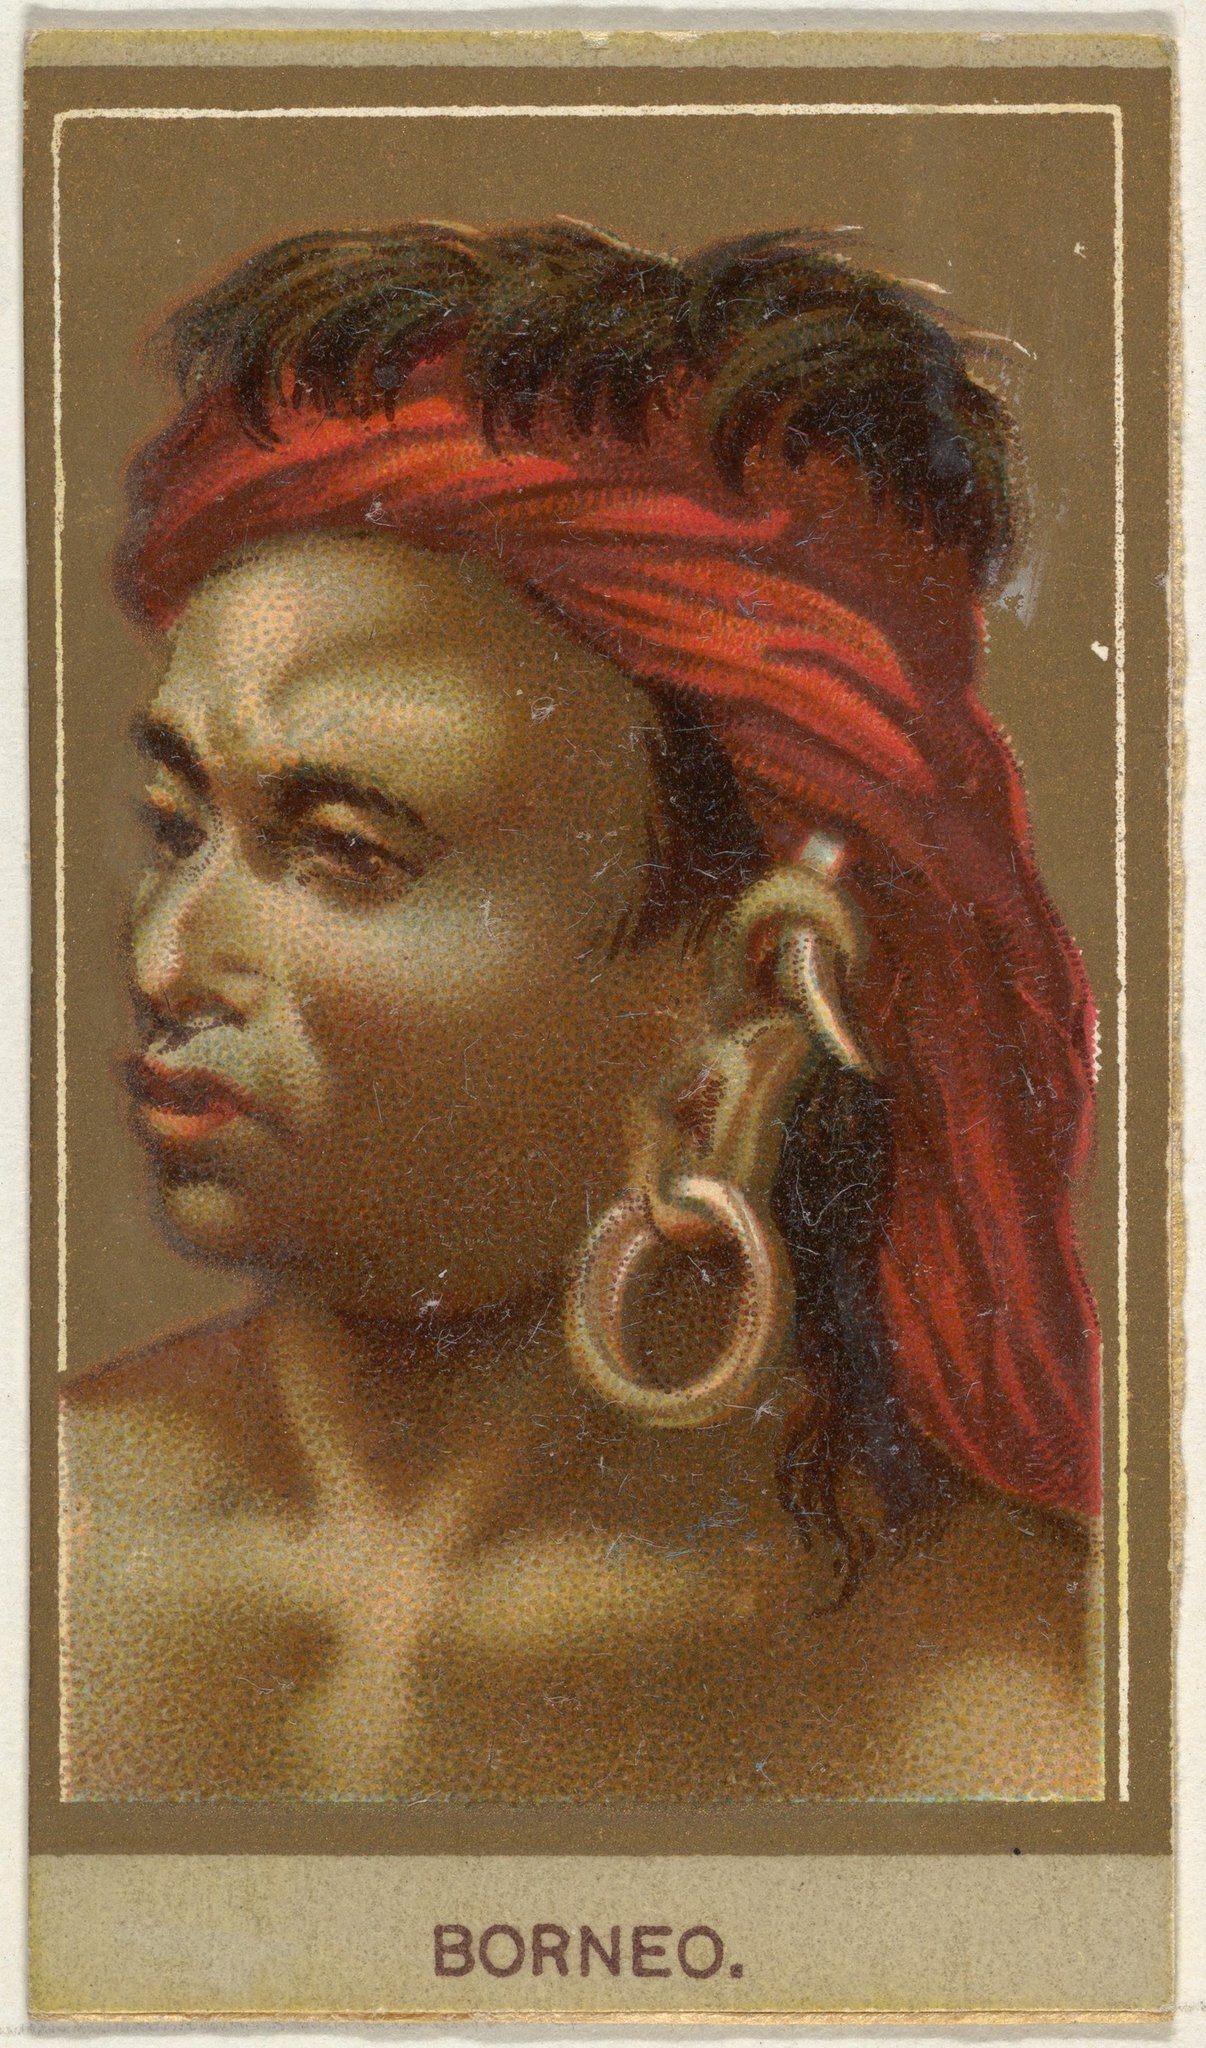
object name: print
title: Borneo, from the Races of Mankind series (T181) issued by Abdul Cigarettes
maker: abdul cigarettes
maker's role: publisher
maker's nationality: american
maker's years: 1881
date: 1881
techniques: color lithograph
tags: men